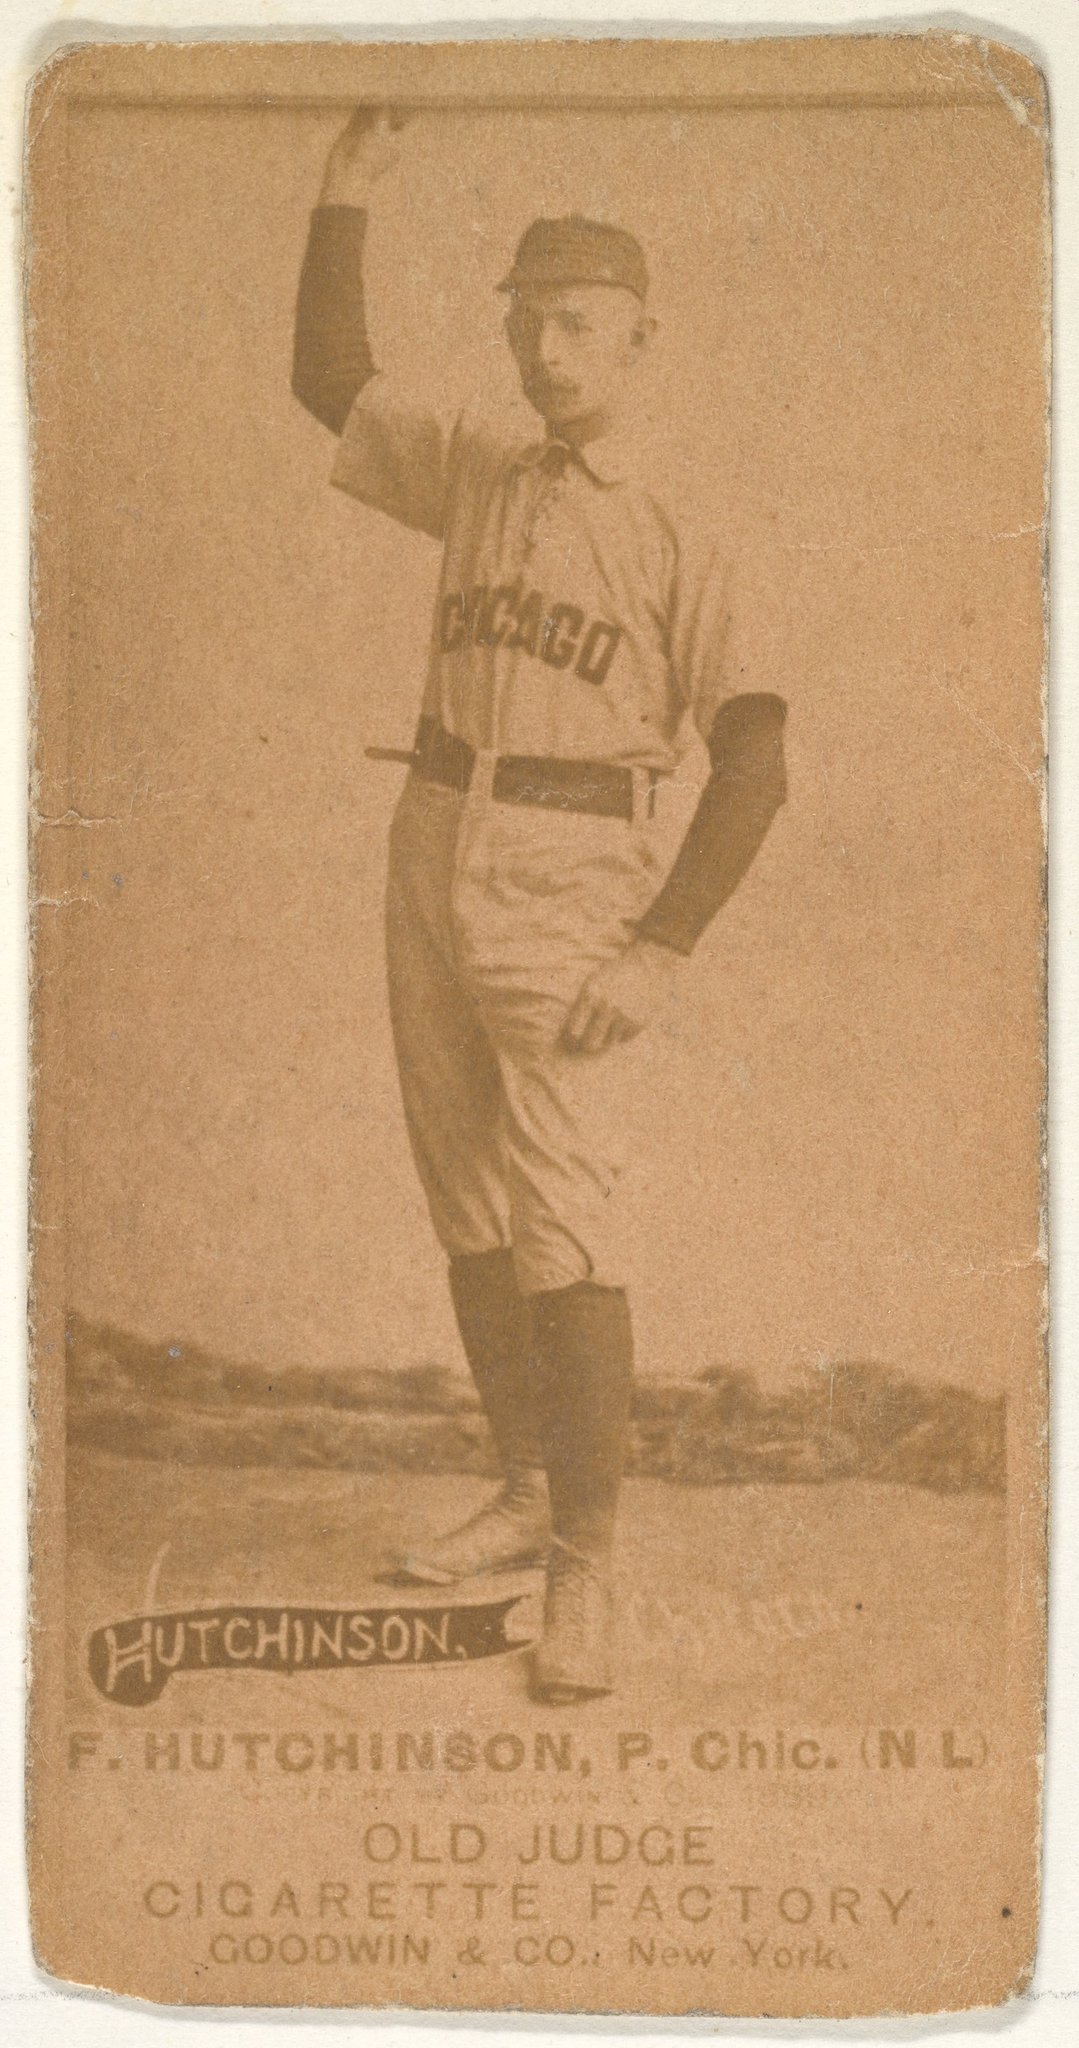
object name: baseball card, photograph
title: F. Hutchinson, Pitcher, Chicago, from the Old Judge series (N172) for Old Judge Cigarettes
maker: goodwin & company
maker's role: publisher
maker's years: 1850-1950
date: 1887-1890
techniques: albumen silver print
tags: men,portraits,baseball,athletes